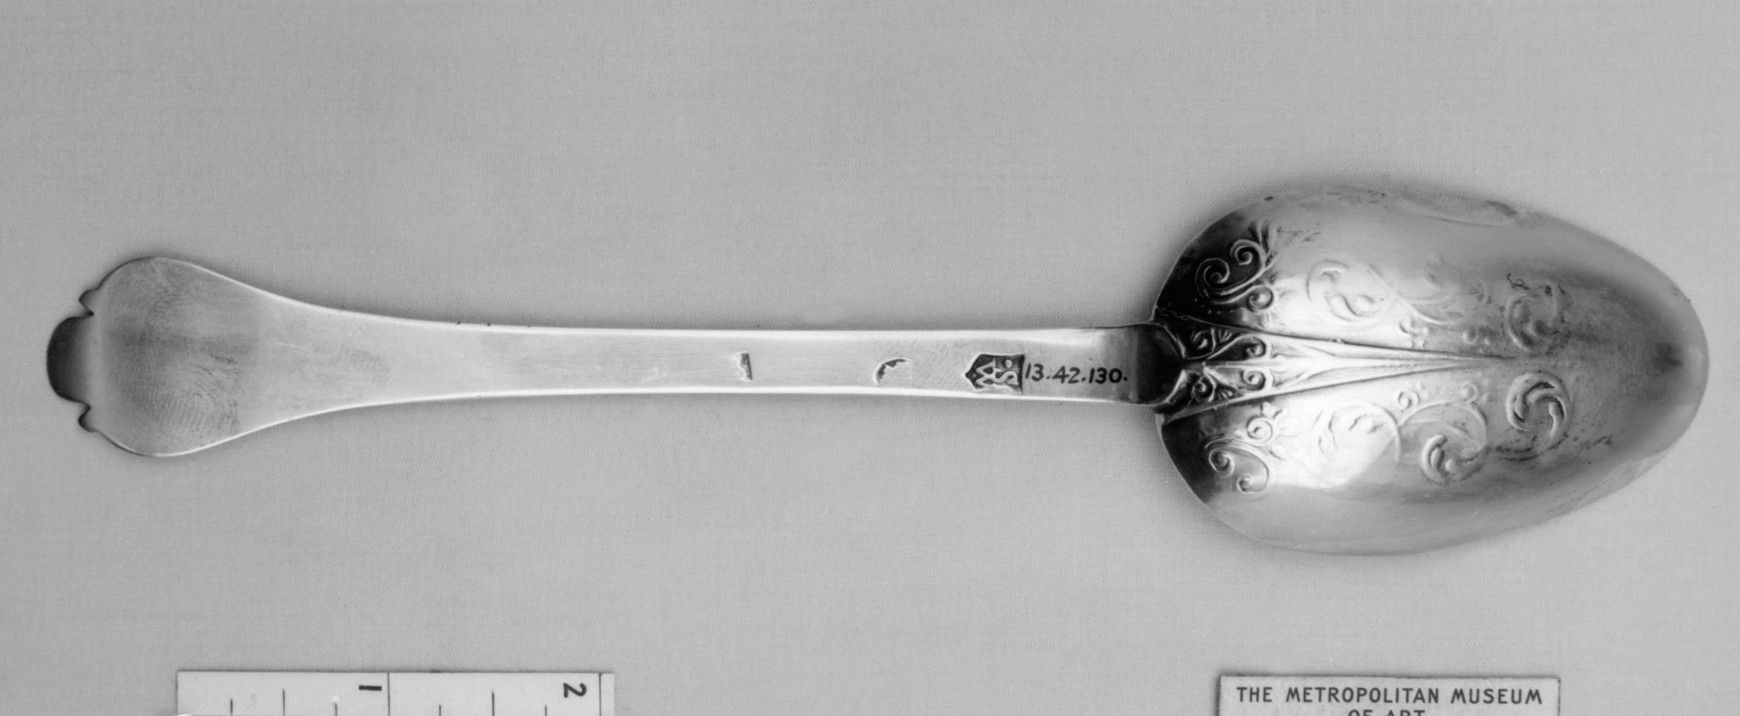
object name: spoon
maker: william scarlett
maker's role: maker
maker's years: 1689-1697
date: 1680-1690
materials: silver